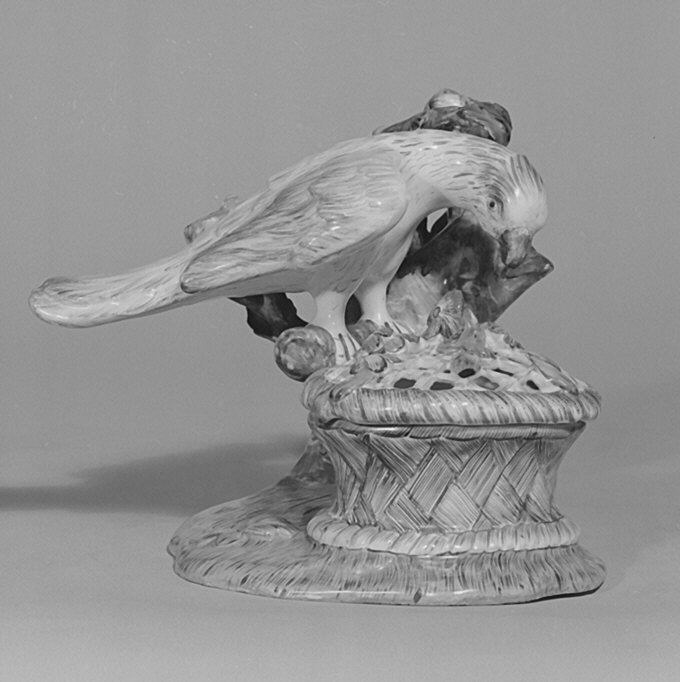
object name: figure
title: Parrot with spread wings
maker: johannes zeschinger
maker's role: decorator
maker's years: 1723-1823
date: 1750-1755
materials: faience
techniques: glazing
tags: parrots